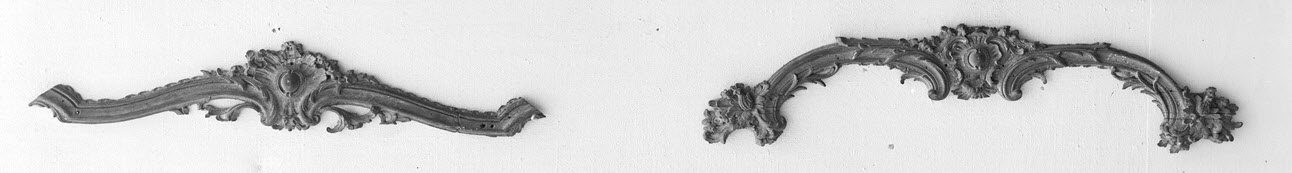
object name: frame fragment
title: Pair of frame fragments (cross-bar)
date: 1701-1750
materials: wood